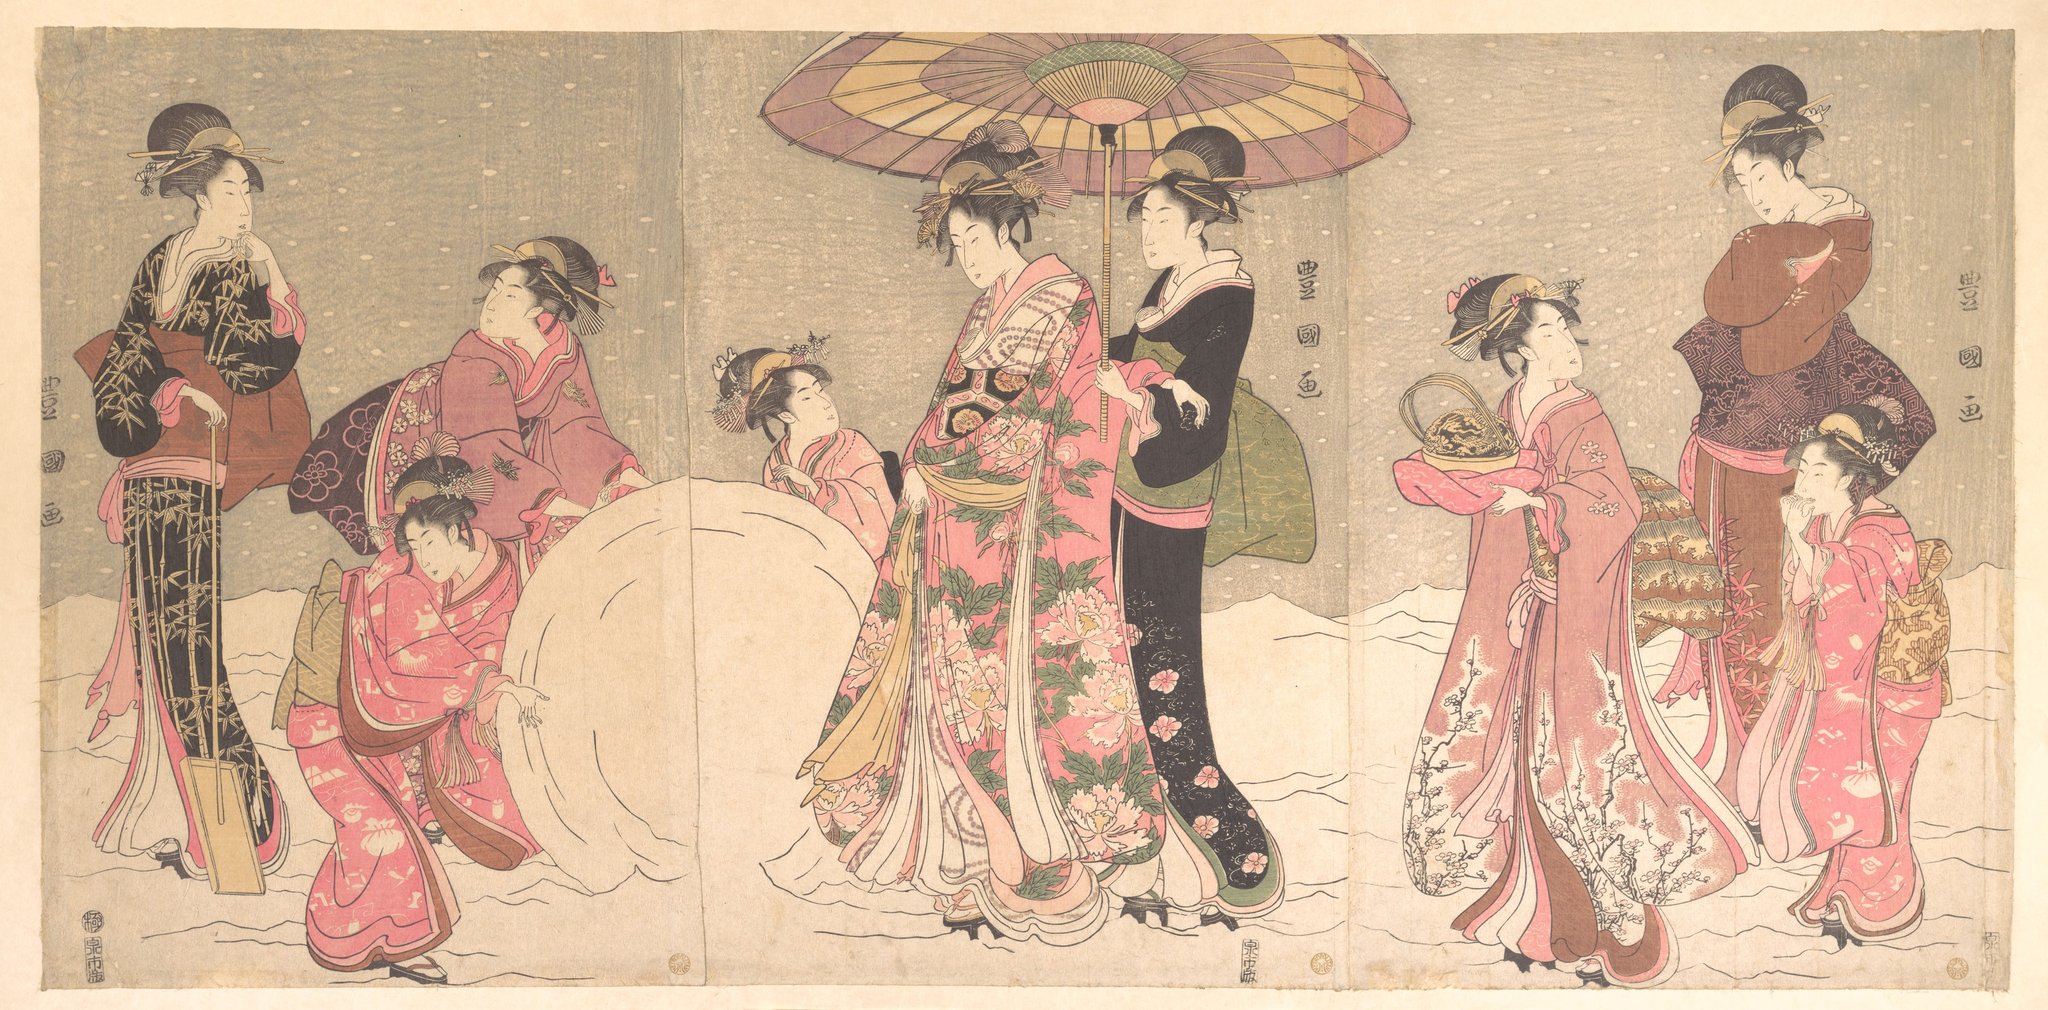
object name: print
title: Courtesans and Attendants Making a Giant Snowball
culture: japanese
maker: utagawa toyokuni i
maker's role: artist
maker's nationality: japanese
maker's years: 1769-1825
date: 1796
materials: ink, paper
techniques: woodblock print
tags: women,winter,snow